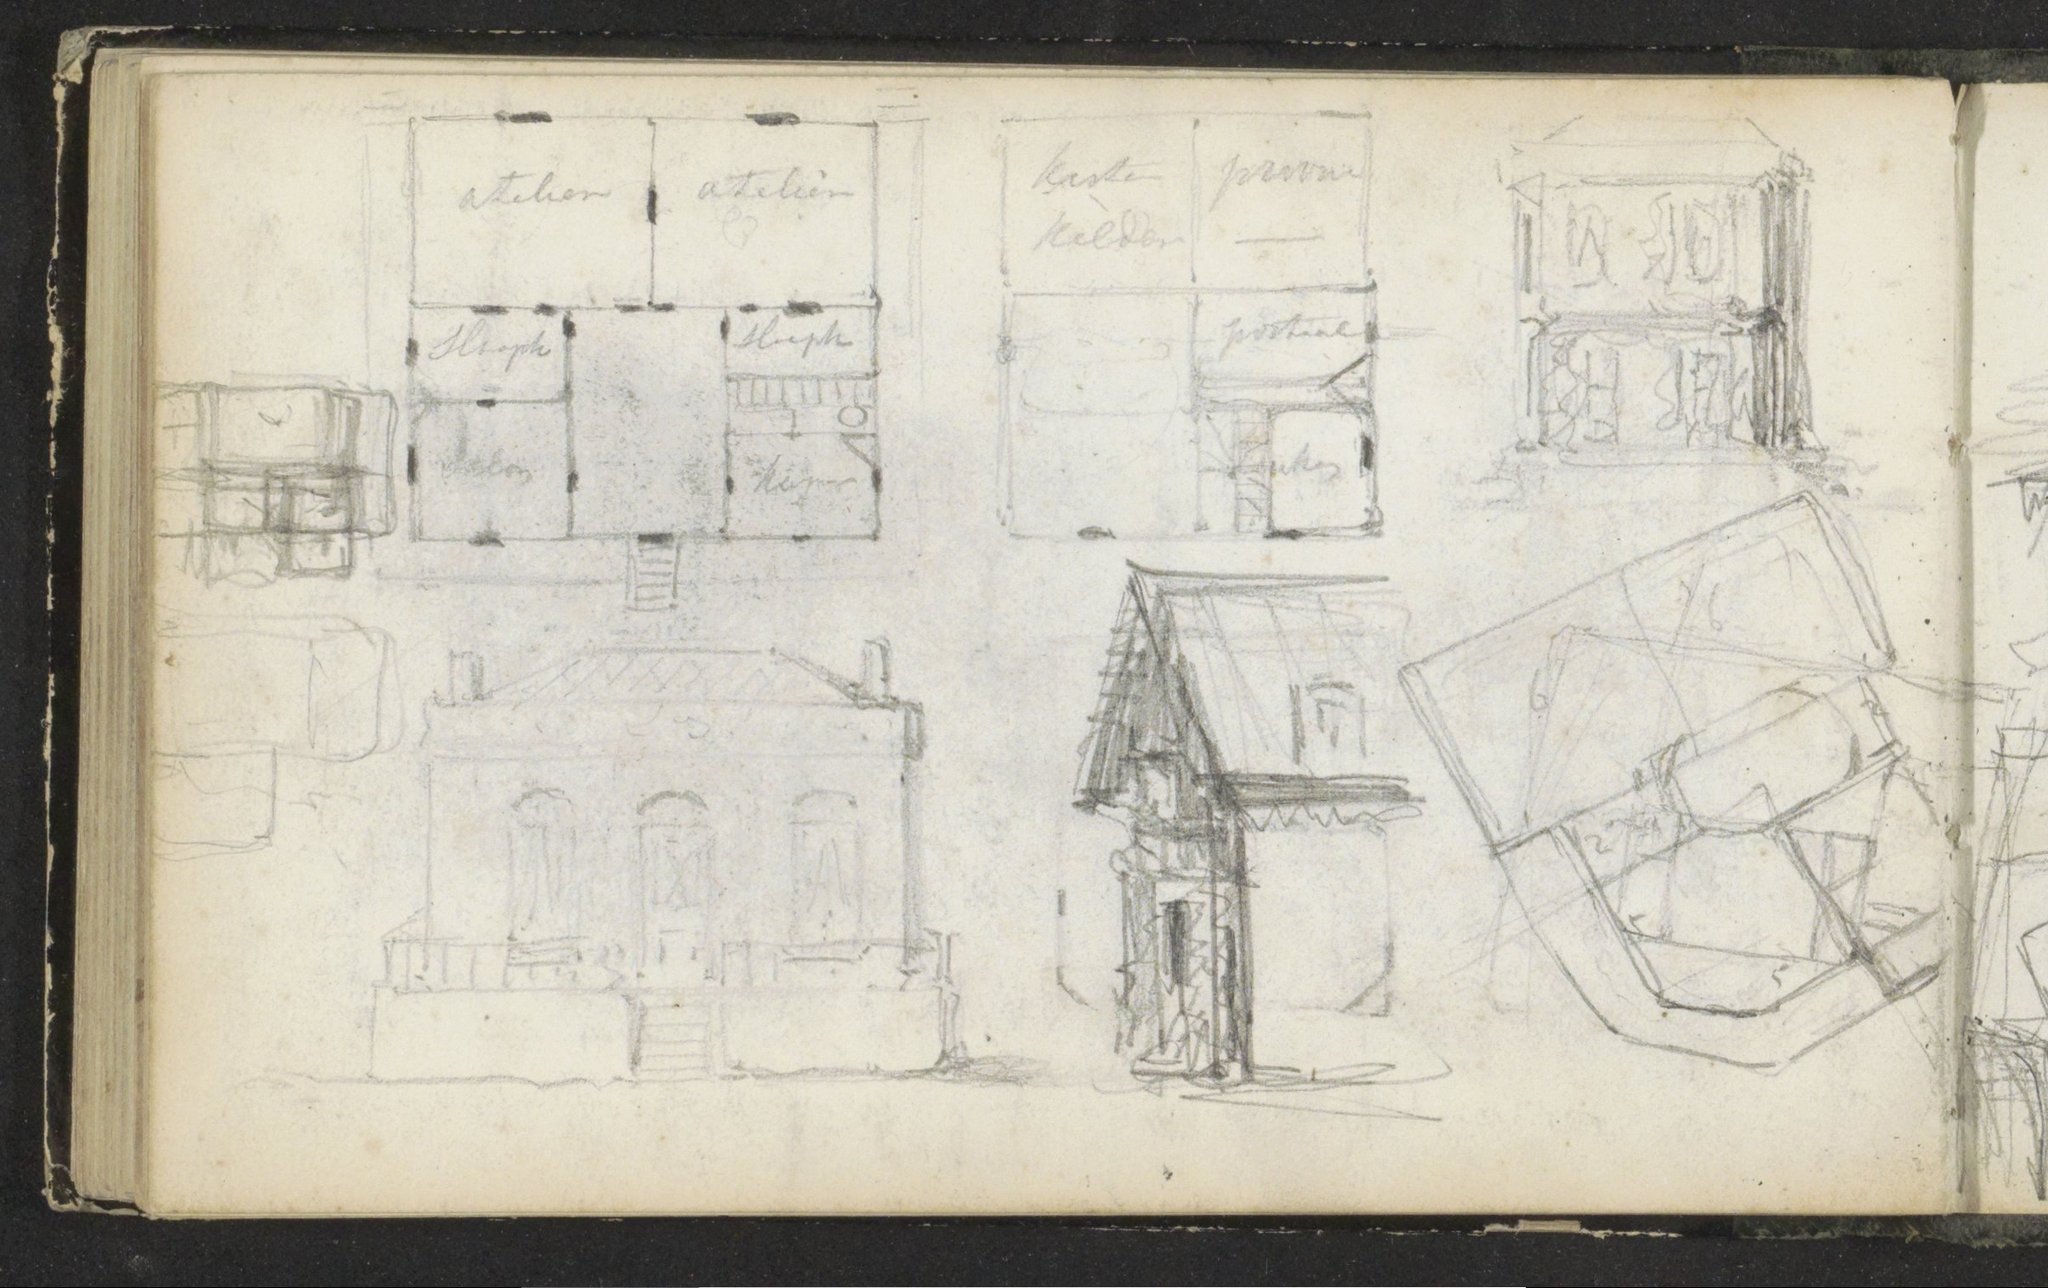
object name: sketchbook leaf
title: Aanzichten van Villa Grada en een ontwerp voor de plattegrond van de villa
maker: maria vos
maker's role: draughtsman, painter, print maker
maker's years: 1824-1906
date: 1856-1870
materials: paper, pencil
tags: plan ~ architecture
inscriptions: annotation: ‘[...]’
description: In 1870 lieten Maria Vos en haar vriendin Adriana Haanen in Oosterbeek een eigen huis met de naam Villa Grada bouwen.